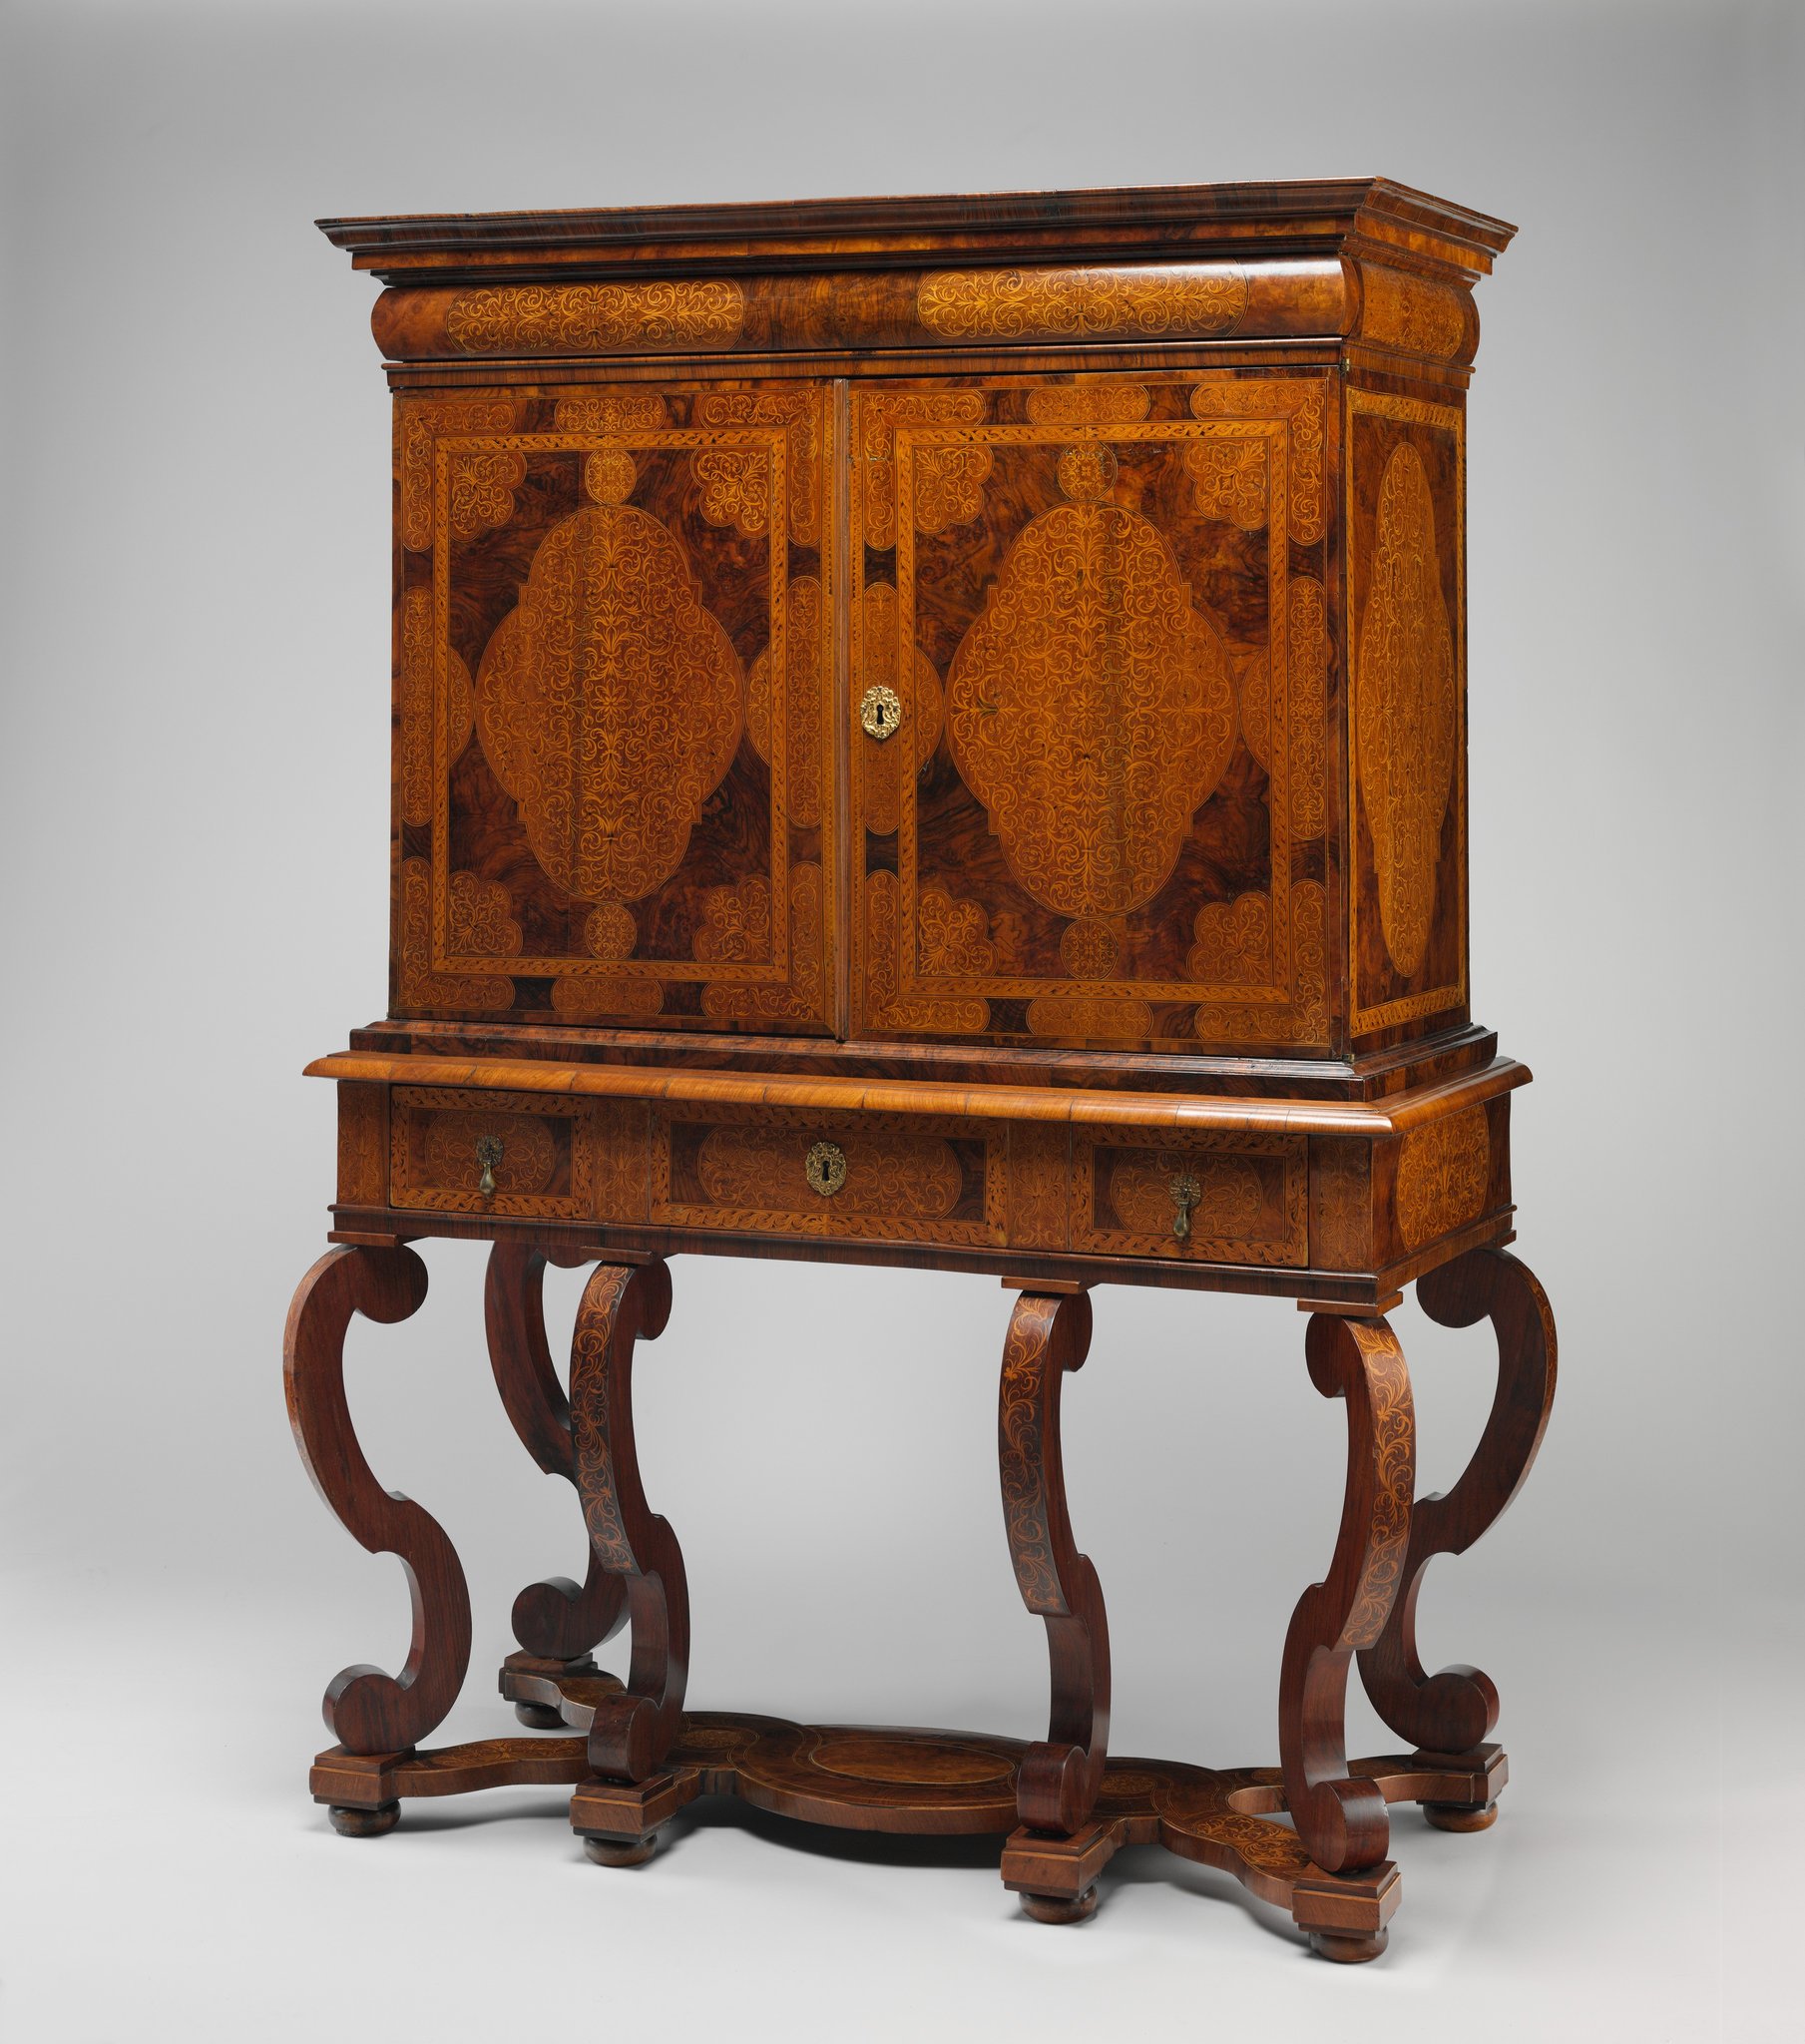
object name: cabinet on stand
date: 1700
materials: brass, wood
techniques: veneering